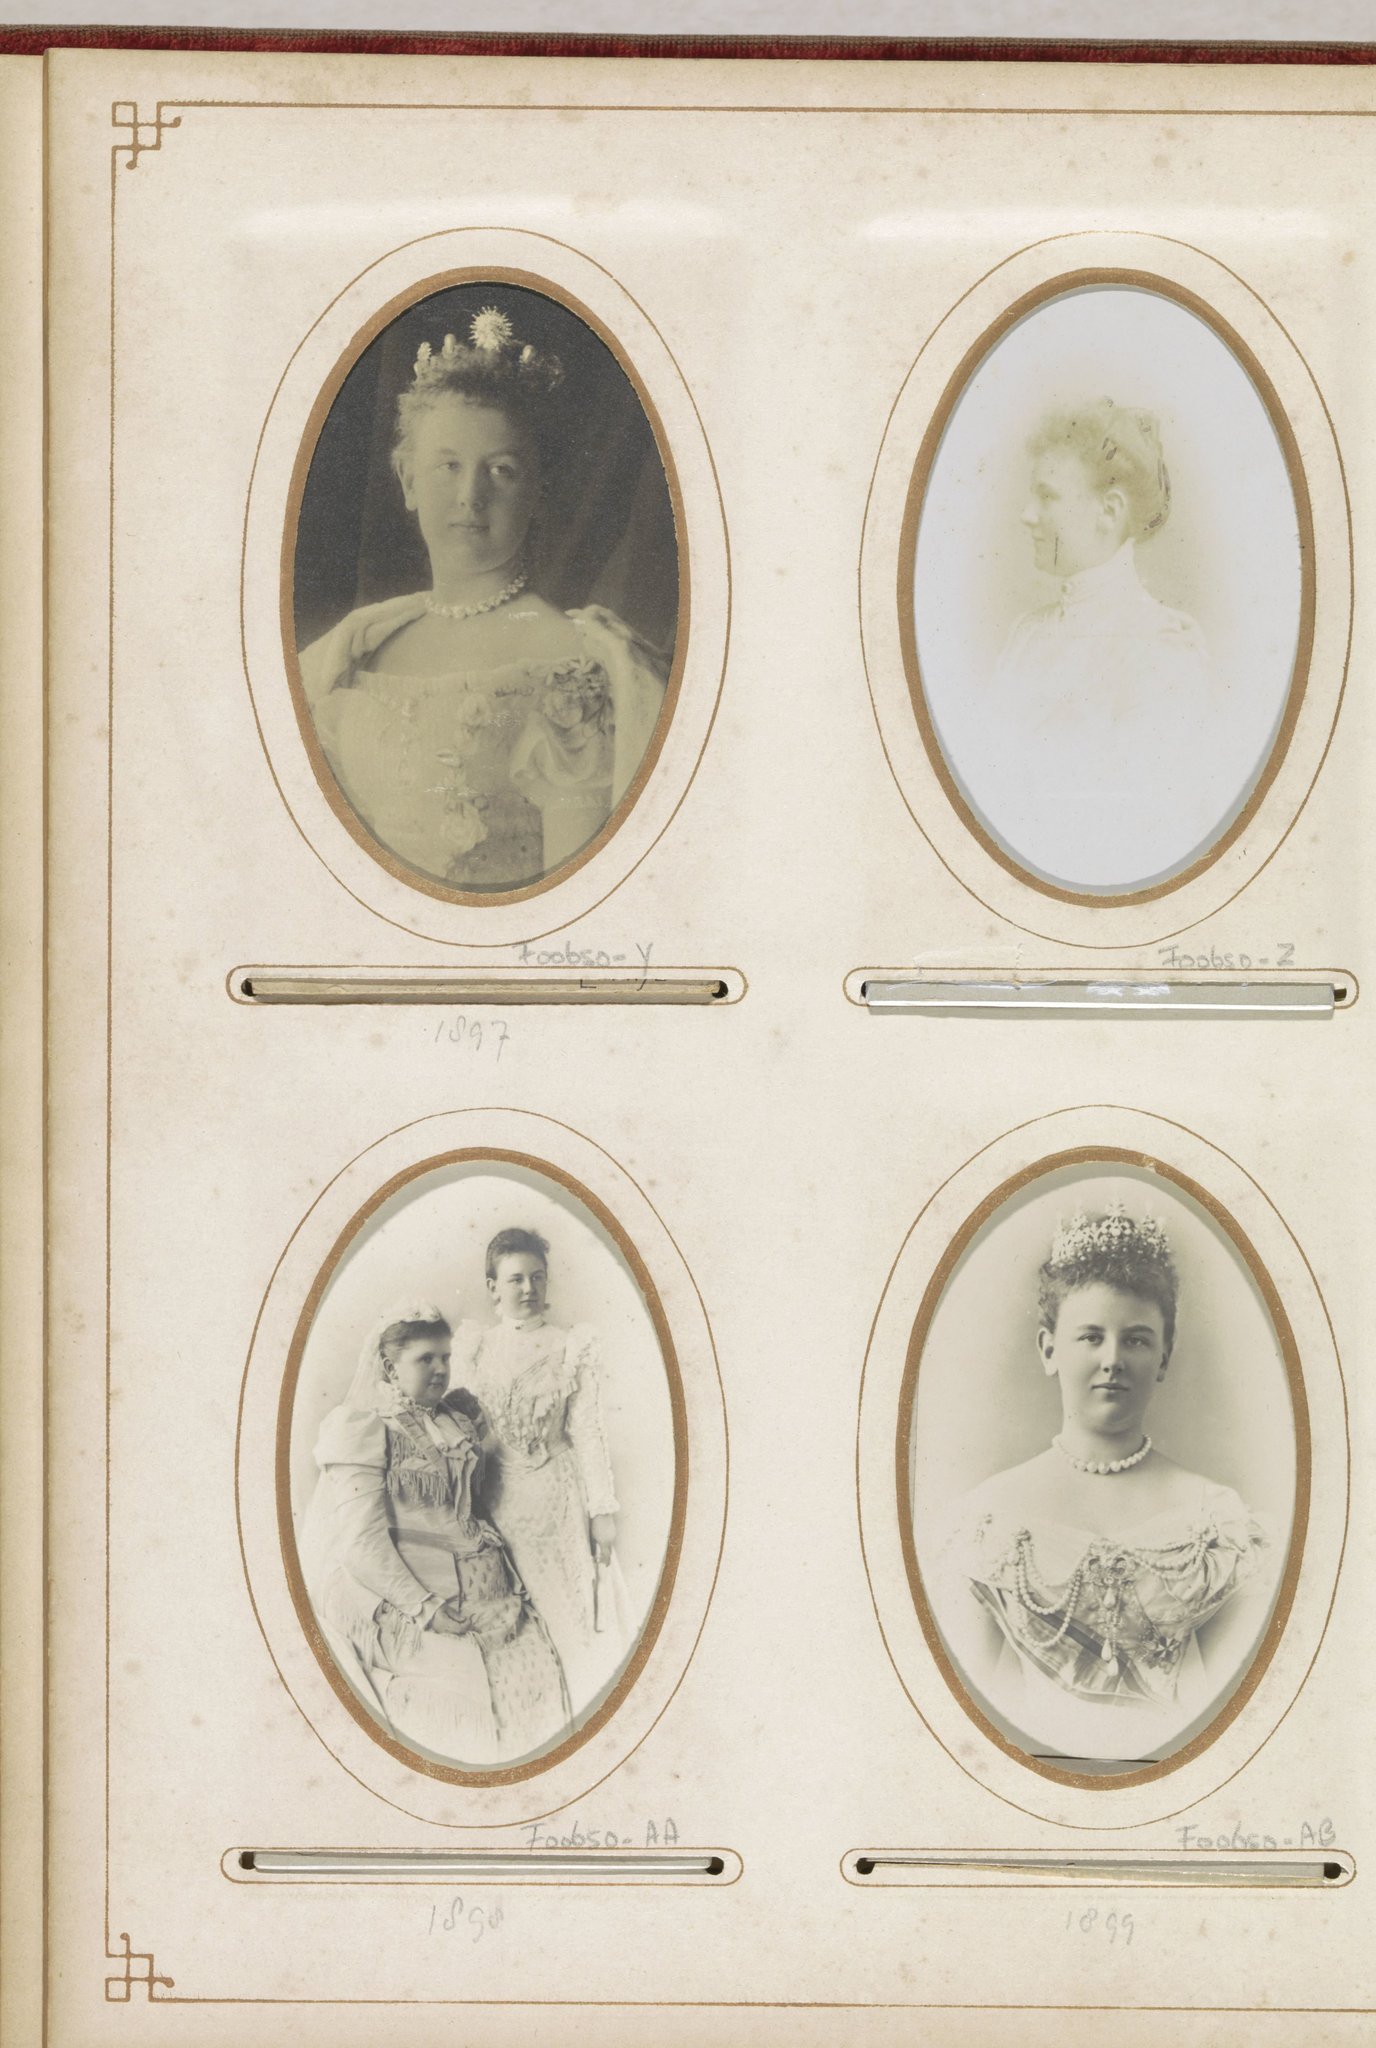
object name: album leaf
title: Portret van koningin Wilhelmina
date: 1898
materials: paper, cardboard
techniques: retouching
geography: the hague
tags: the hague, print maker, wilhelmina of the netherlands, historical persons - bb - woman, queen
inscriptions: inscription: ‘De Lavieter & Co. La Haye.’